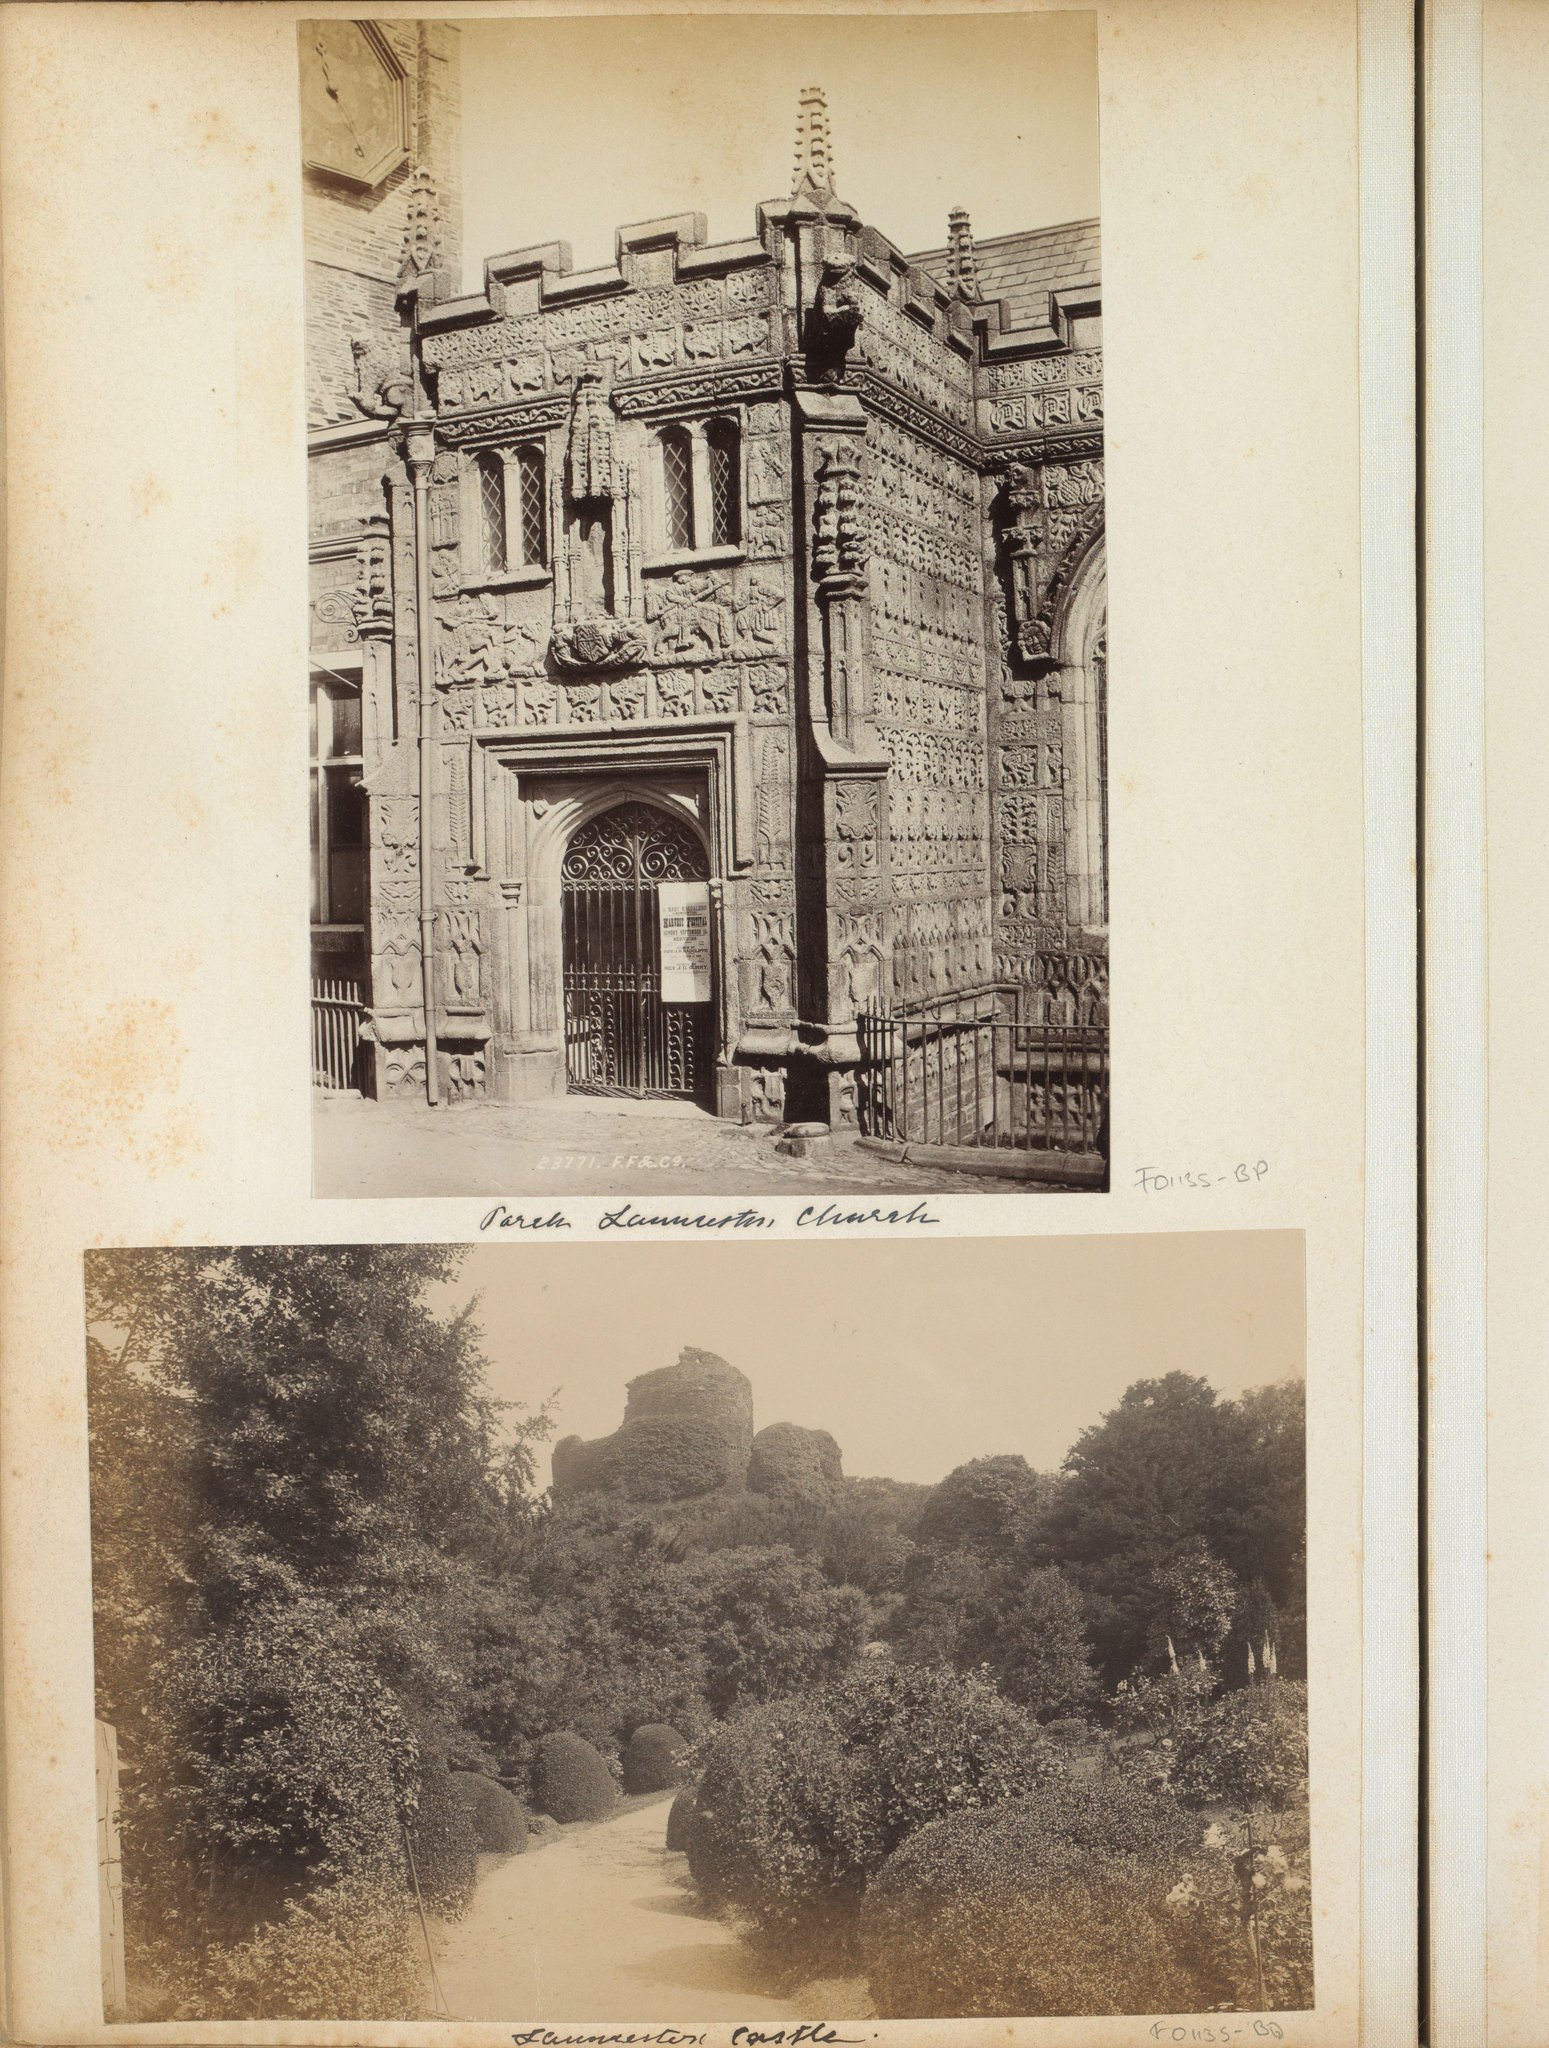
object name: photograph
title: Exterieur van de Church of St Mary Magdalene in Launceston (Cornwall)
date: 1899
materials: paper, photographic support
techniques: albumen print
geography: launceston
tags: church (exterior), sculpture (+ relief ~ sculpture)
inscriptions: negative number: ‘23771’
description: Onderdeel van Reisalbum met foto's van bezienswaardigheden in Engeland en Frankrijk.